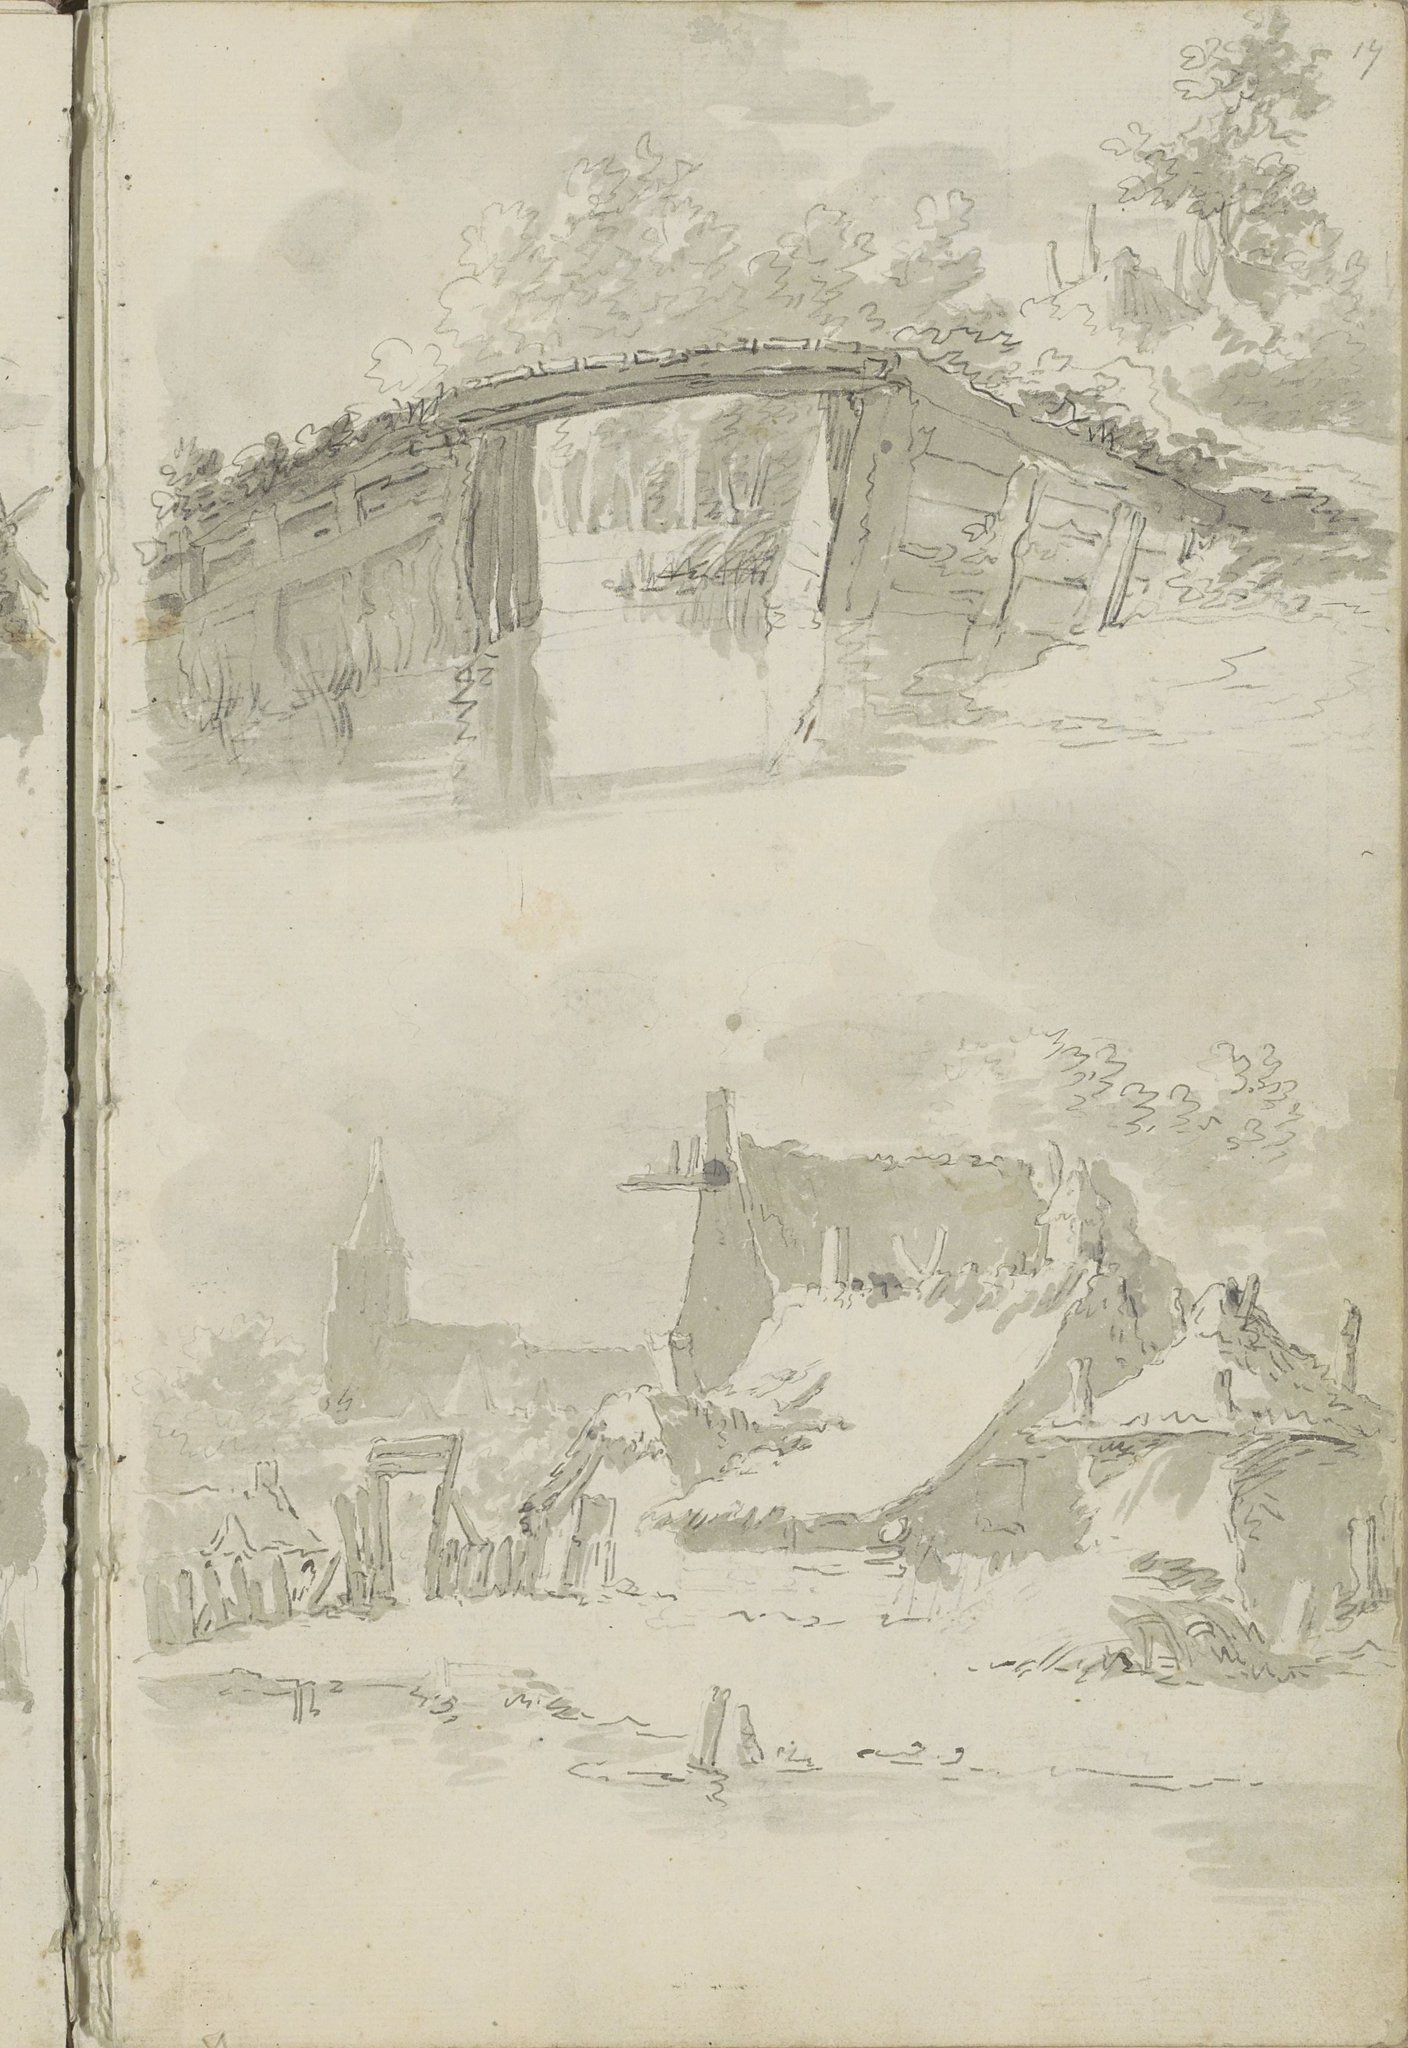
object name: sketchbook leaf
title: Brug en een boerderij met hooimijt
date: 1780-1800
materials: paper, pencil, watercolor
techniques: brush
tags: hay-stack, bridge, farm (building)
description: De boerderij ligt aan de rand van een dorp. Op de achtergrond is de toren van een kerk te zien. Blad 5 recto uit een schetsboek met 25 bladen.